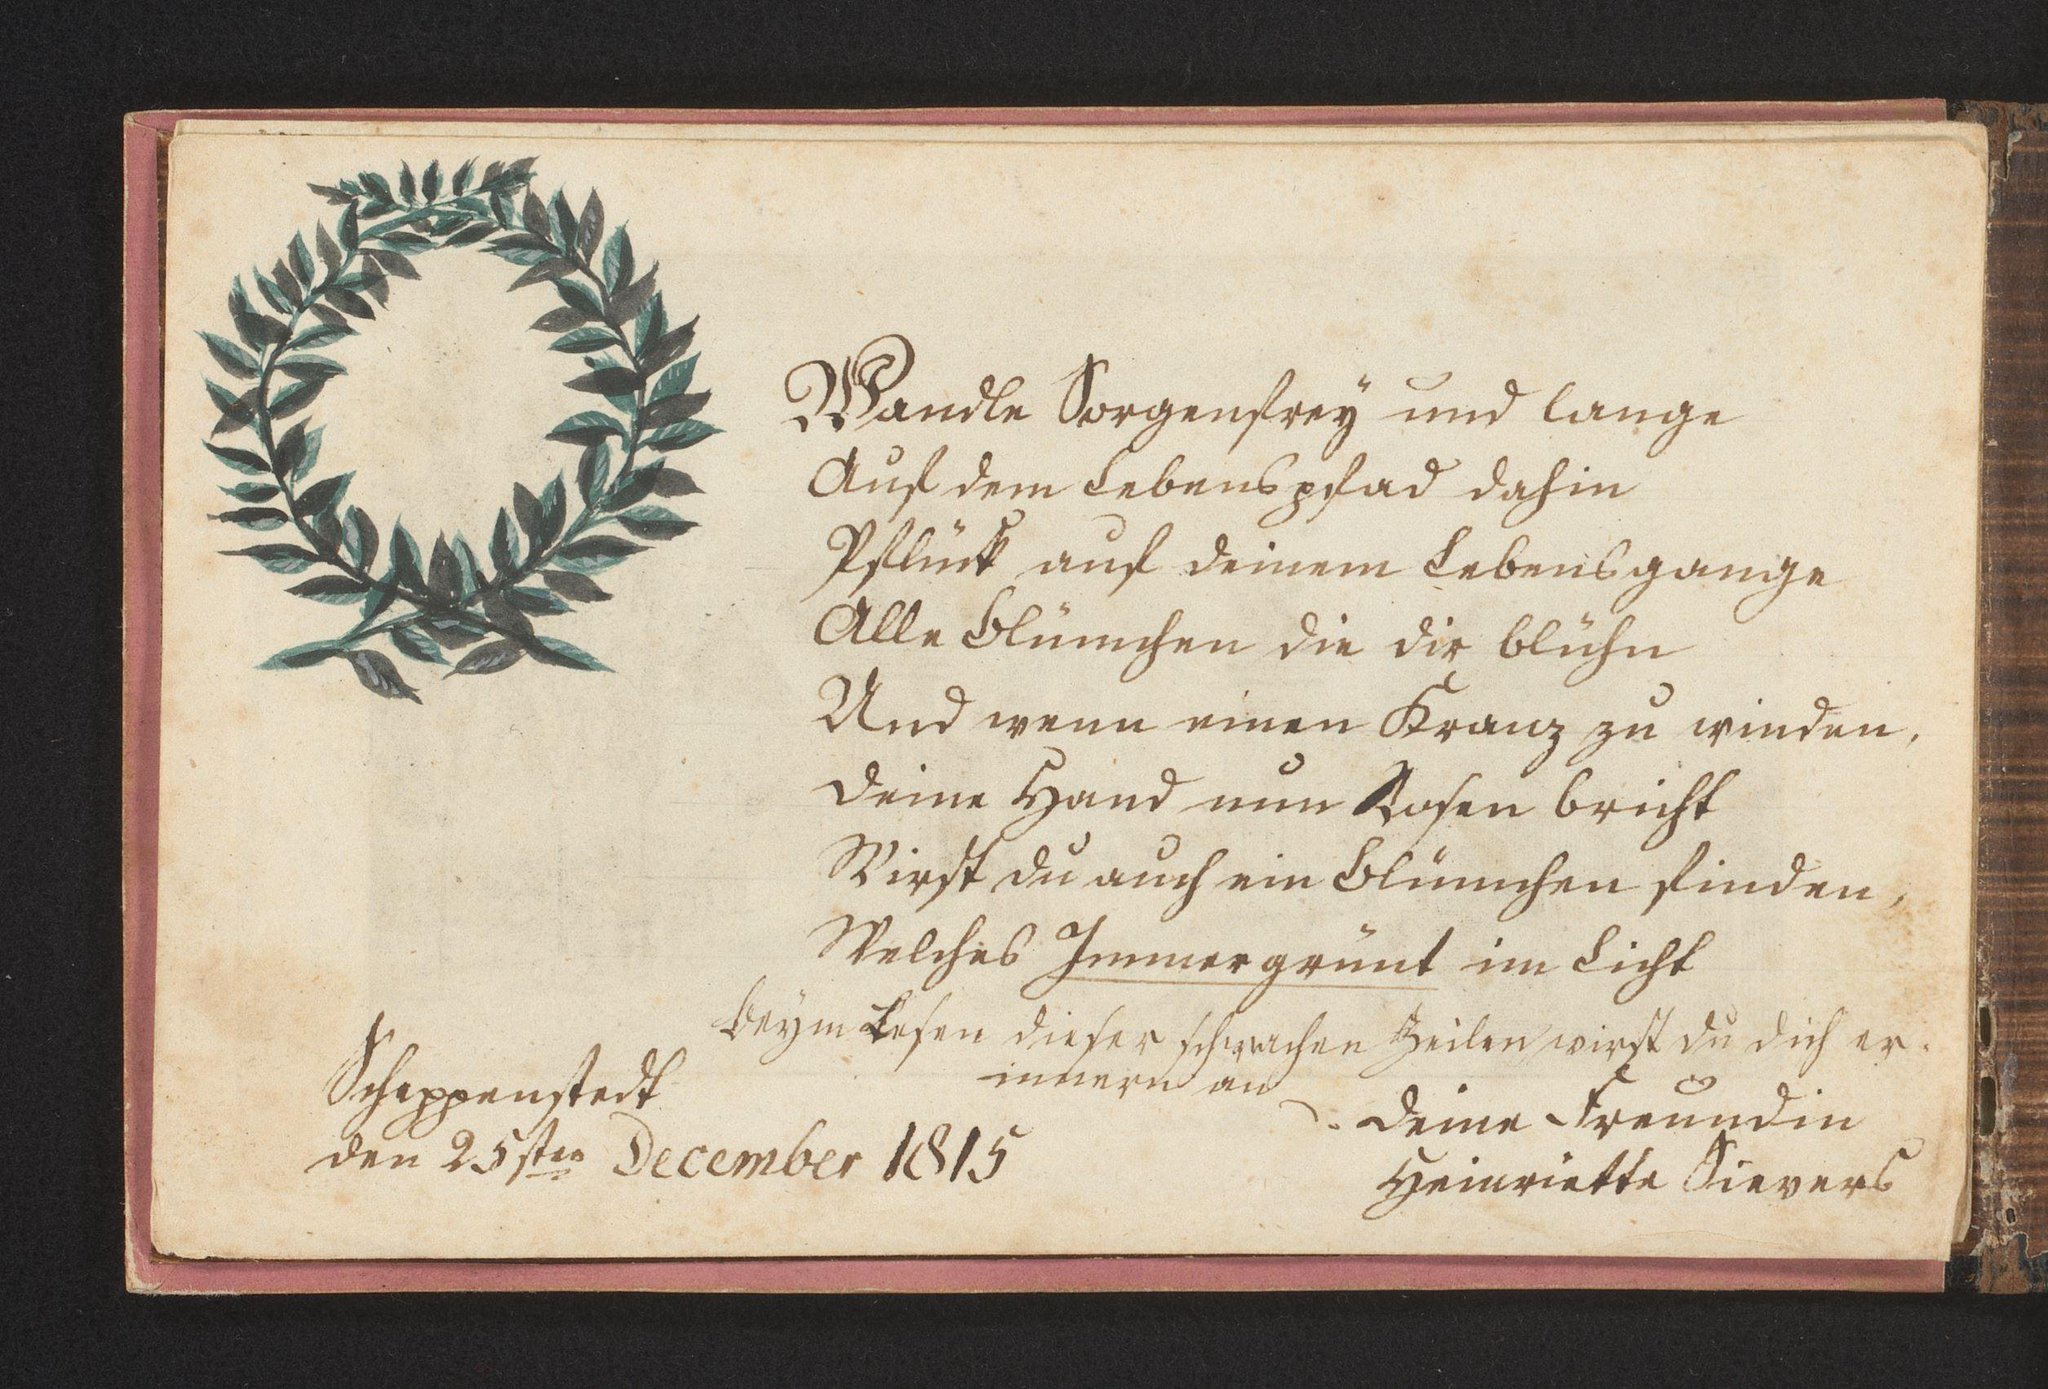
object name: print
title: Tekst en lauwerkrans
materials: paint, ink, paper, watercolor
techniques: brush, writing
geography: gottingen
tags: 'album amicorum', 'stammbuch', garland, wreath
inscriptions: tekst, verso, handgeschreven